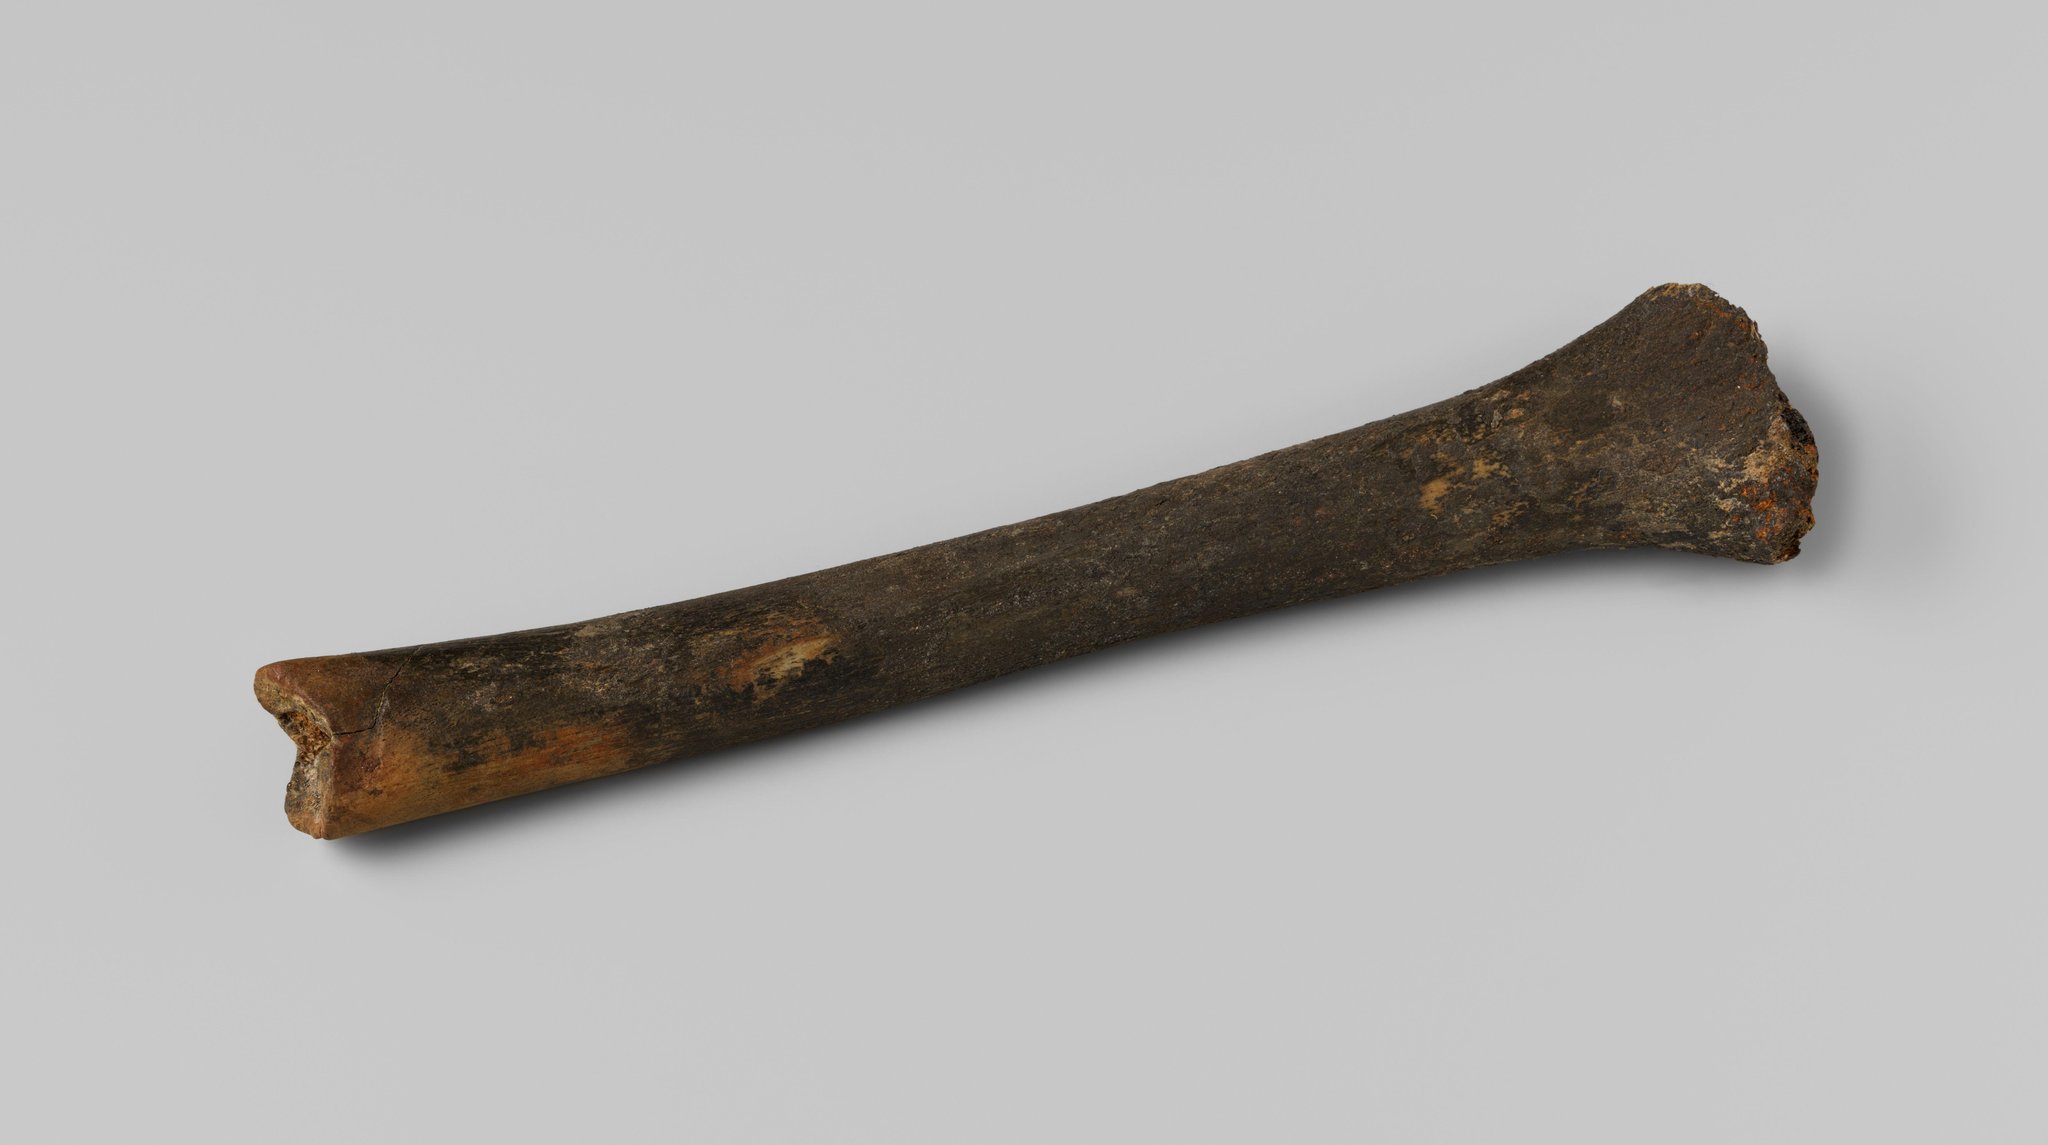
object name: bone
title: Lang bot uit het wrak van de Oostindiëvaarder Hollandia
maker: Anonymous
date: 1700-1743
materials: bone